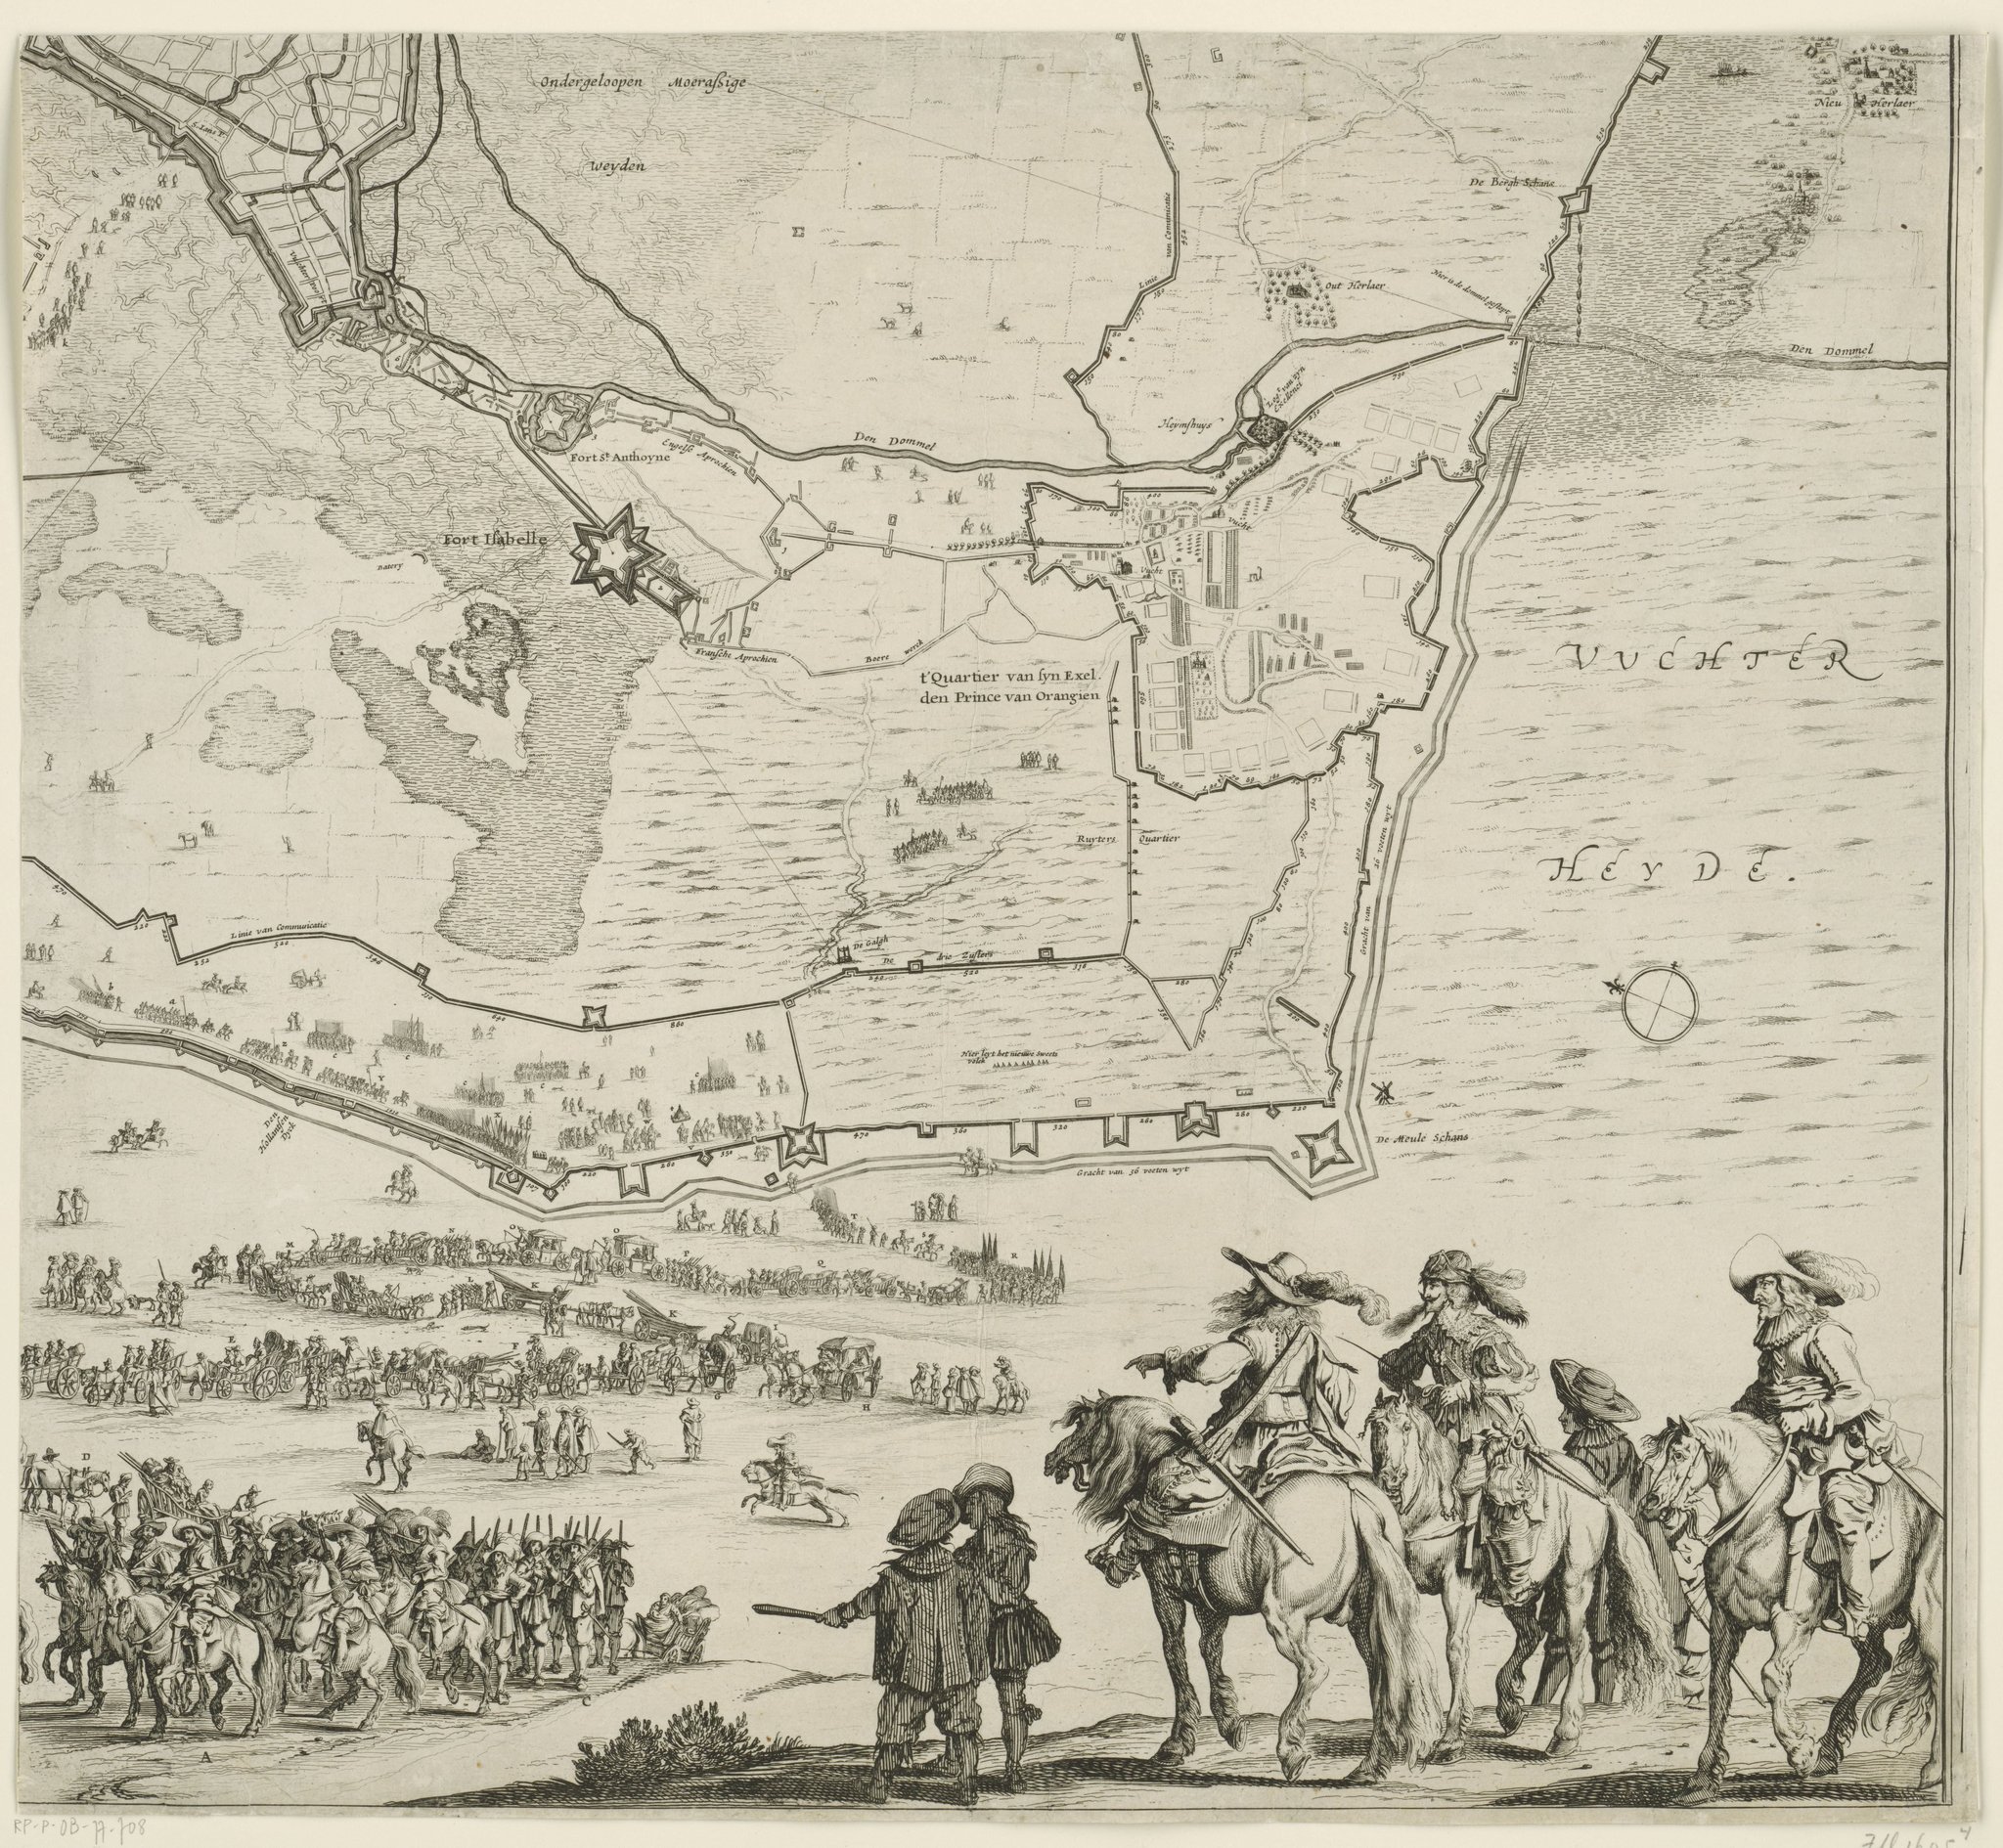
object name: print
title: Beleg en inname van Den Bosch door Frederik Hendrik, 1629, (blad rechtsonder)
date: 1630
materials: paper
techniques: etching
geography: amsterdam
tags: the hague, frederick henry (prince of orange), maps of separate countries or regions, siege, position war, capture of city (after the siege), the defeated (after the battle), den bosch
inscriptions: date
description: Grote kaart van de omsingeling van Den Bosch tijdens het beleg door het Staatse leger onder Frederik Hendrik, van 1 mei tot 17 september 1629. Geheel bestaande uit 4 platen en 4 tekstbladen. Dit is het blad rechtsonder met een deel van de kaart met kwartier Frederik Hendrik. Rechtsonder enkele officieren te paard die toezien het Spaanse garnizoen in stoet de st verlaat.